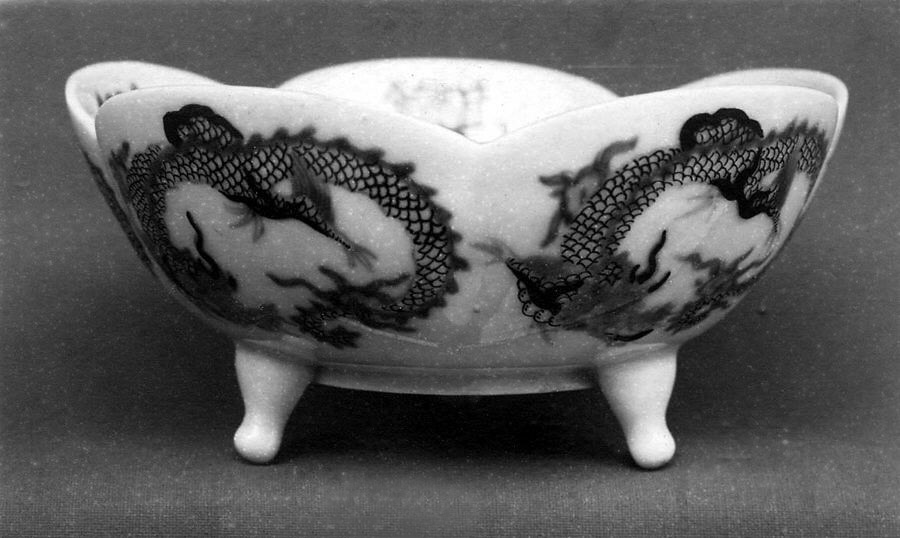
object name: bowl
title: Bowl on Three Feet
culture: japanese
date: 1760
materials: glaze, porcelain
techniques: polychrome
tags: dragons